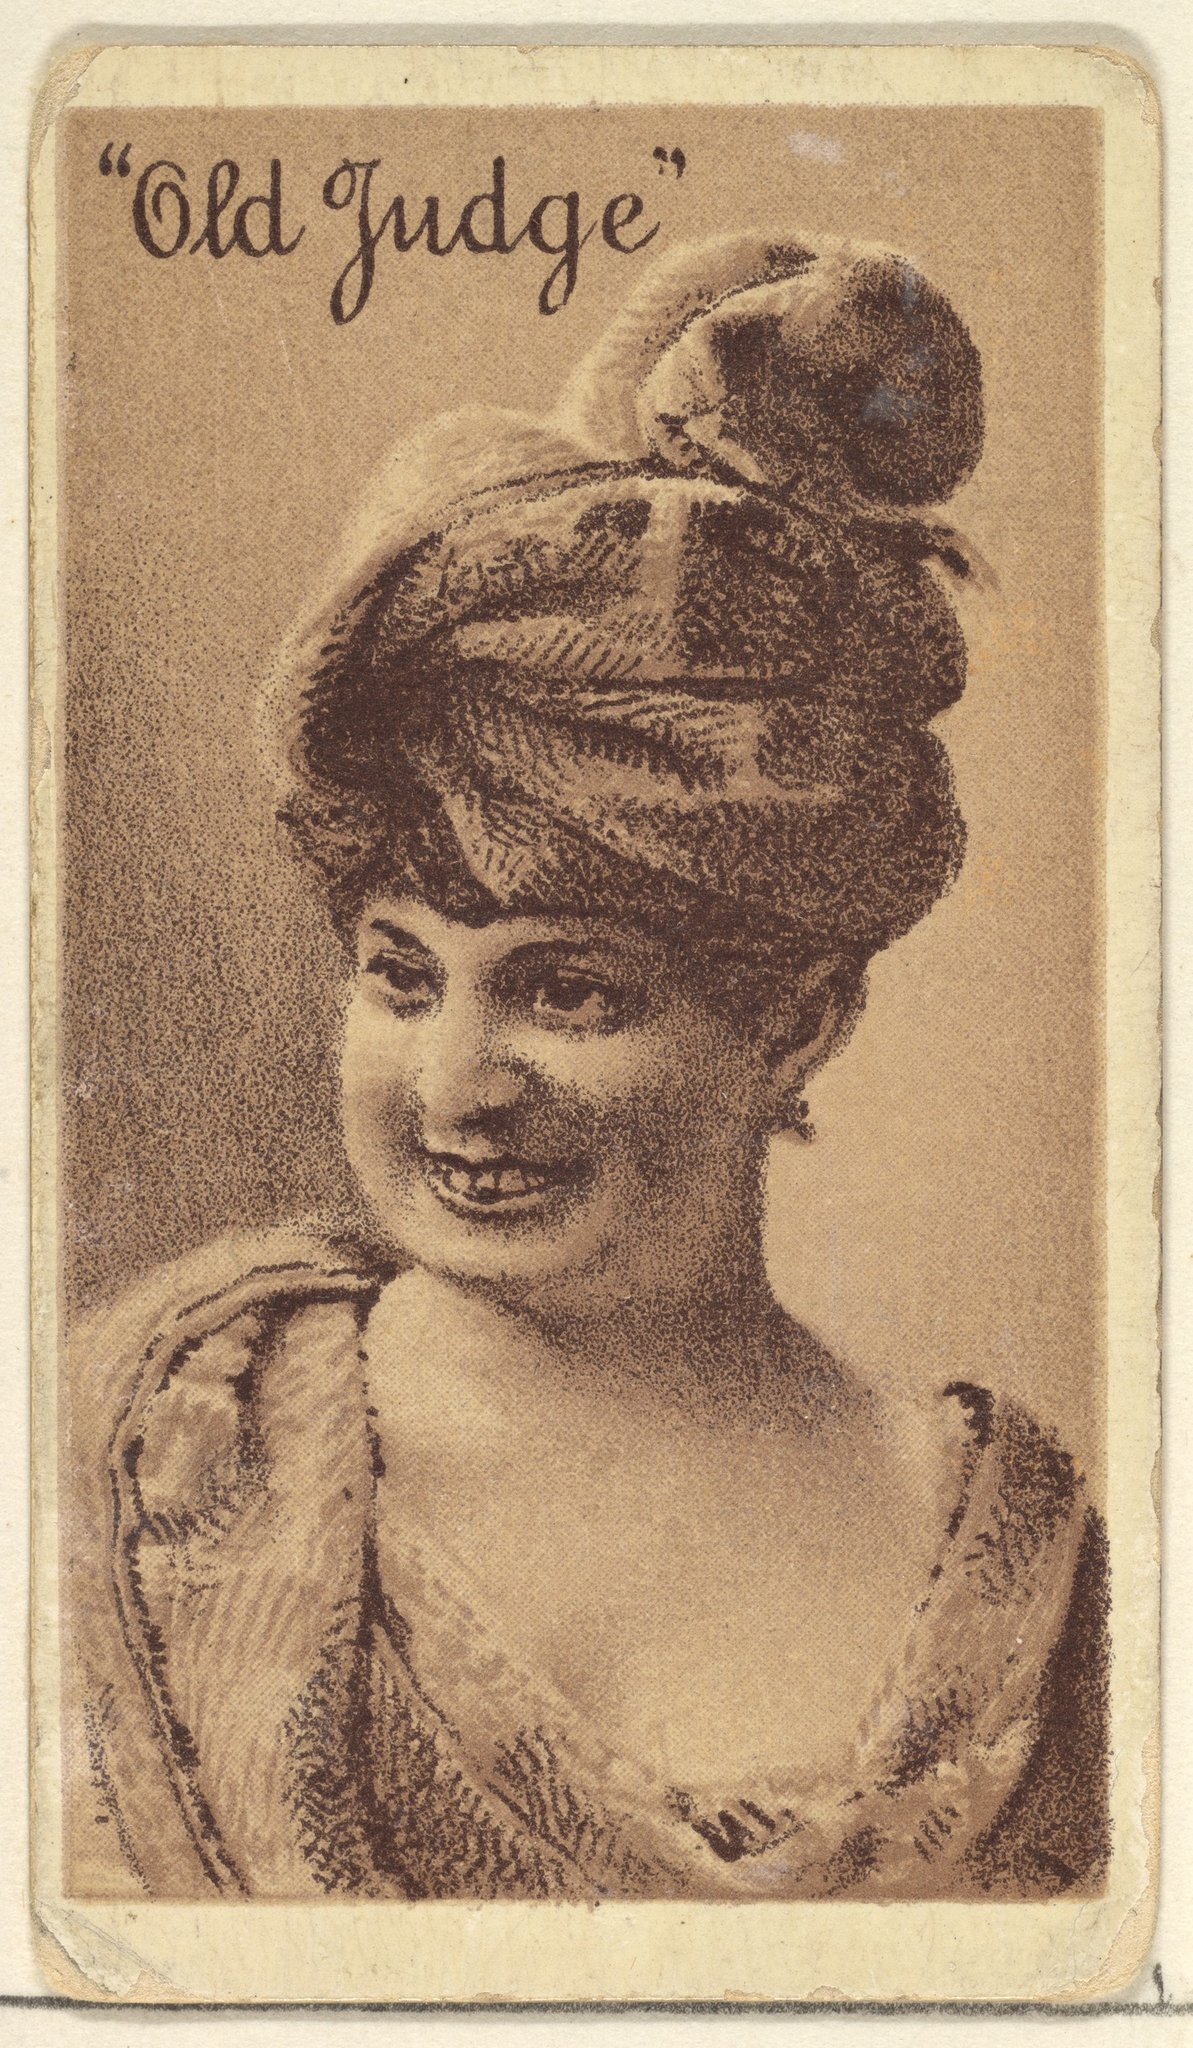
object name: print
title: Actress from the Old Judge series (N167) for Old Judge Cigarettes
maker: goodwin & company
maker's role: publisher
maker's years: 1850-1950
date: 1886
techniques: lithography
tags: portraits,women